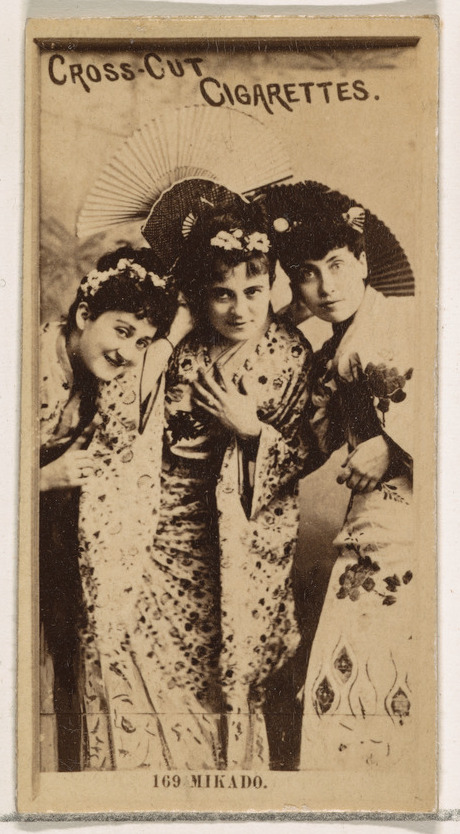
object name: print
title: Card Number 169, The Mikado, from the Actors and Actresses series (N145-2) issued by Duke Sons & Co. to promote Cross Cut Cigarettes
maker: w. duke, sons & co.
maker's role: publisher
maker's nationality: american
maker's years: 1870-1920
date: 1880-1889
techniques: albumen silver print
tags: portraits,women,actresses